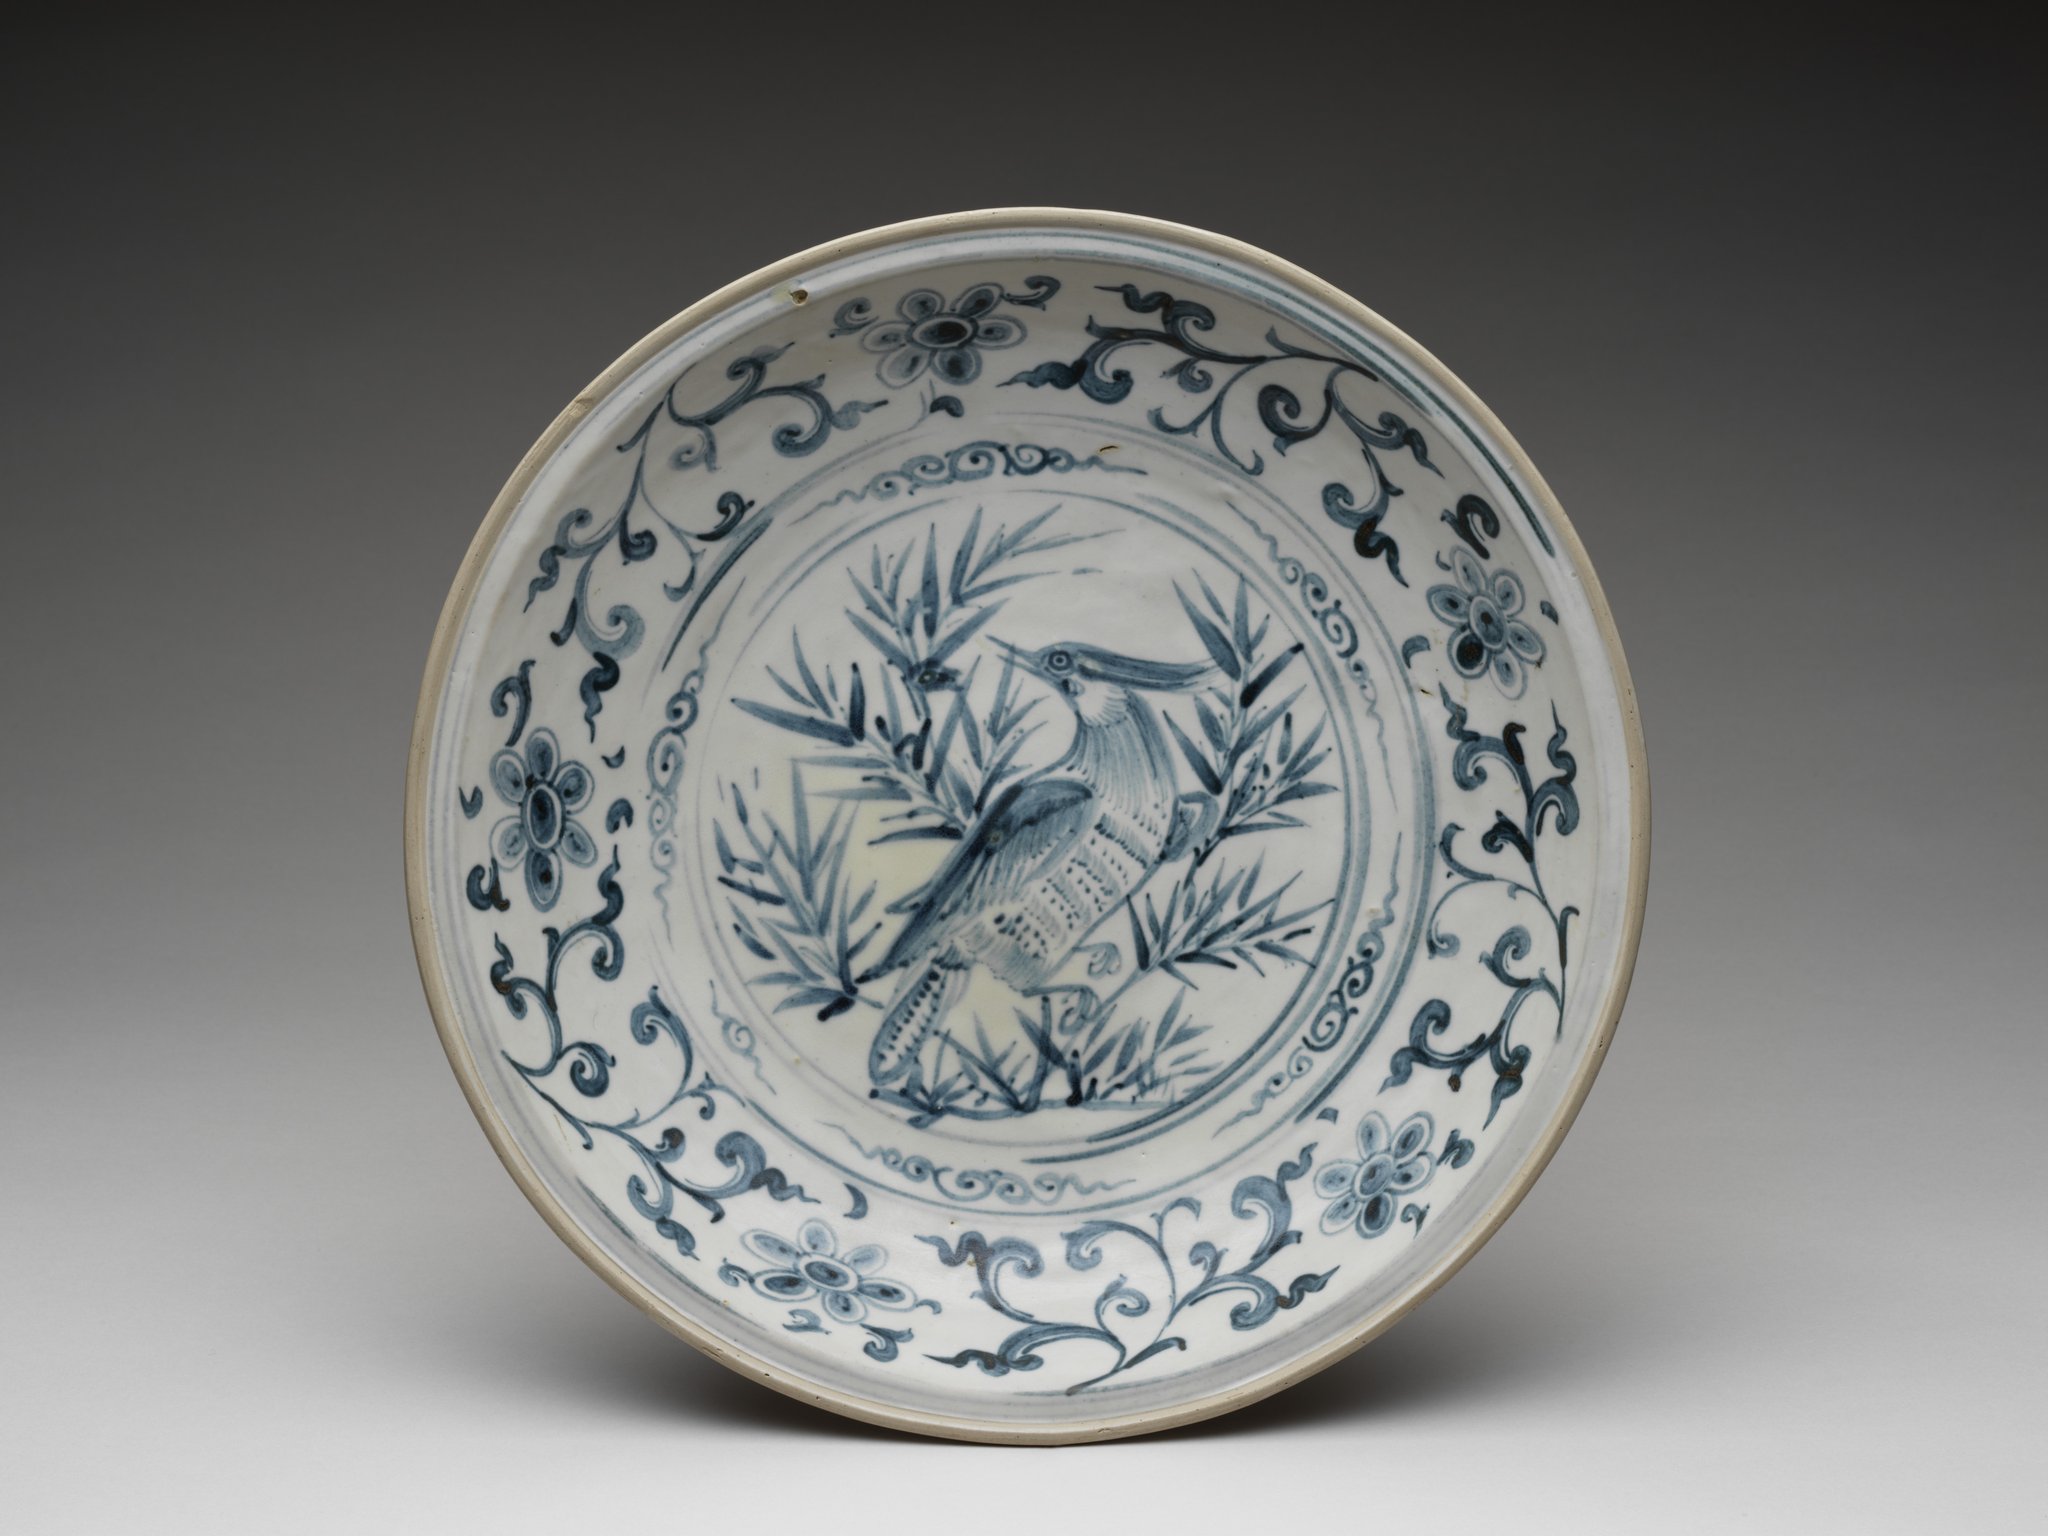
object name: dish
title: Dish with bird amid bamboo design and foliate meander on cavetto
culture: vietnamese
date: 1501-1533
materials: cobalt, glaze, stoneware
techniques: painting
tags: birds